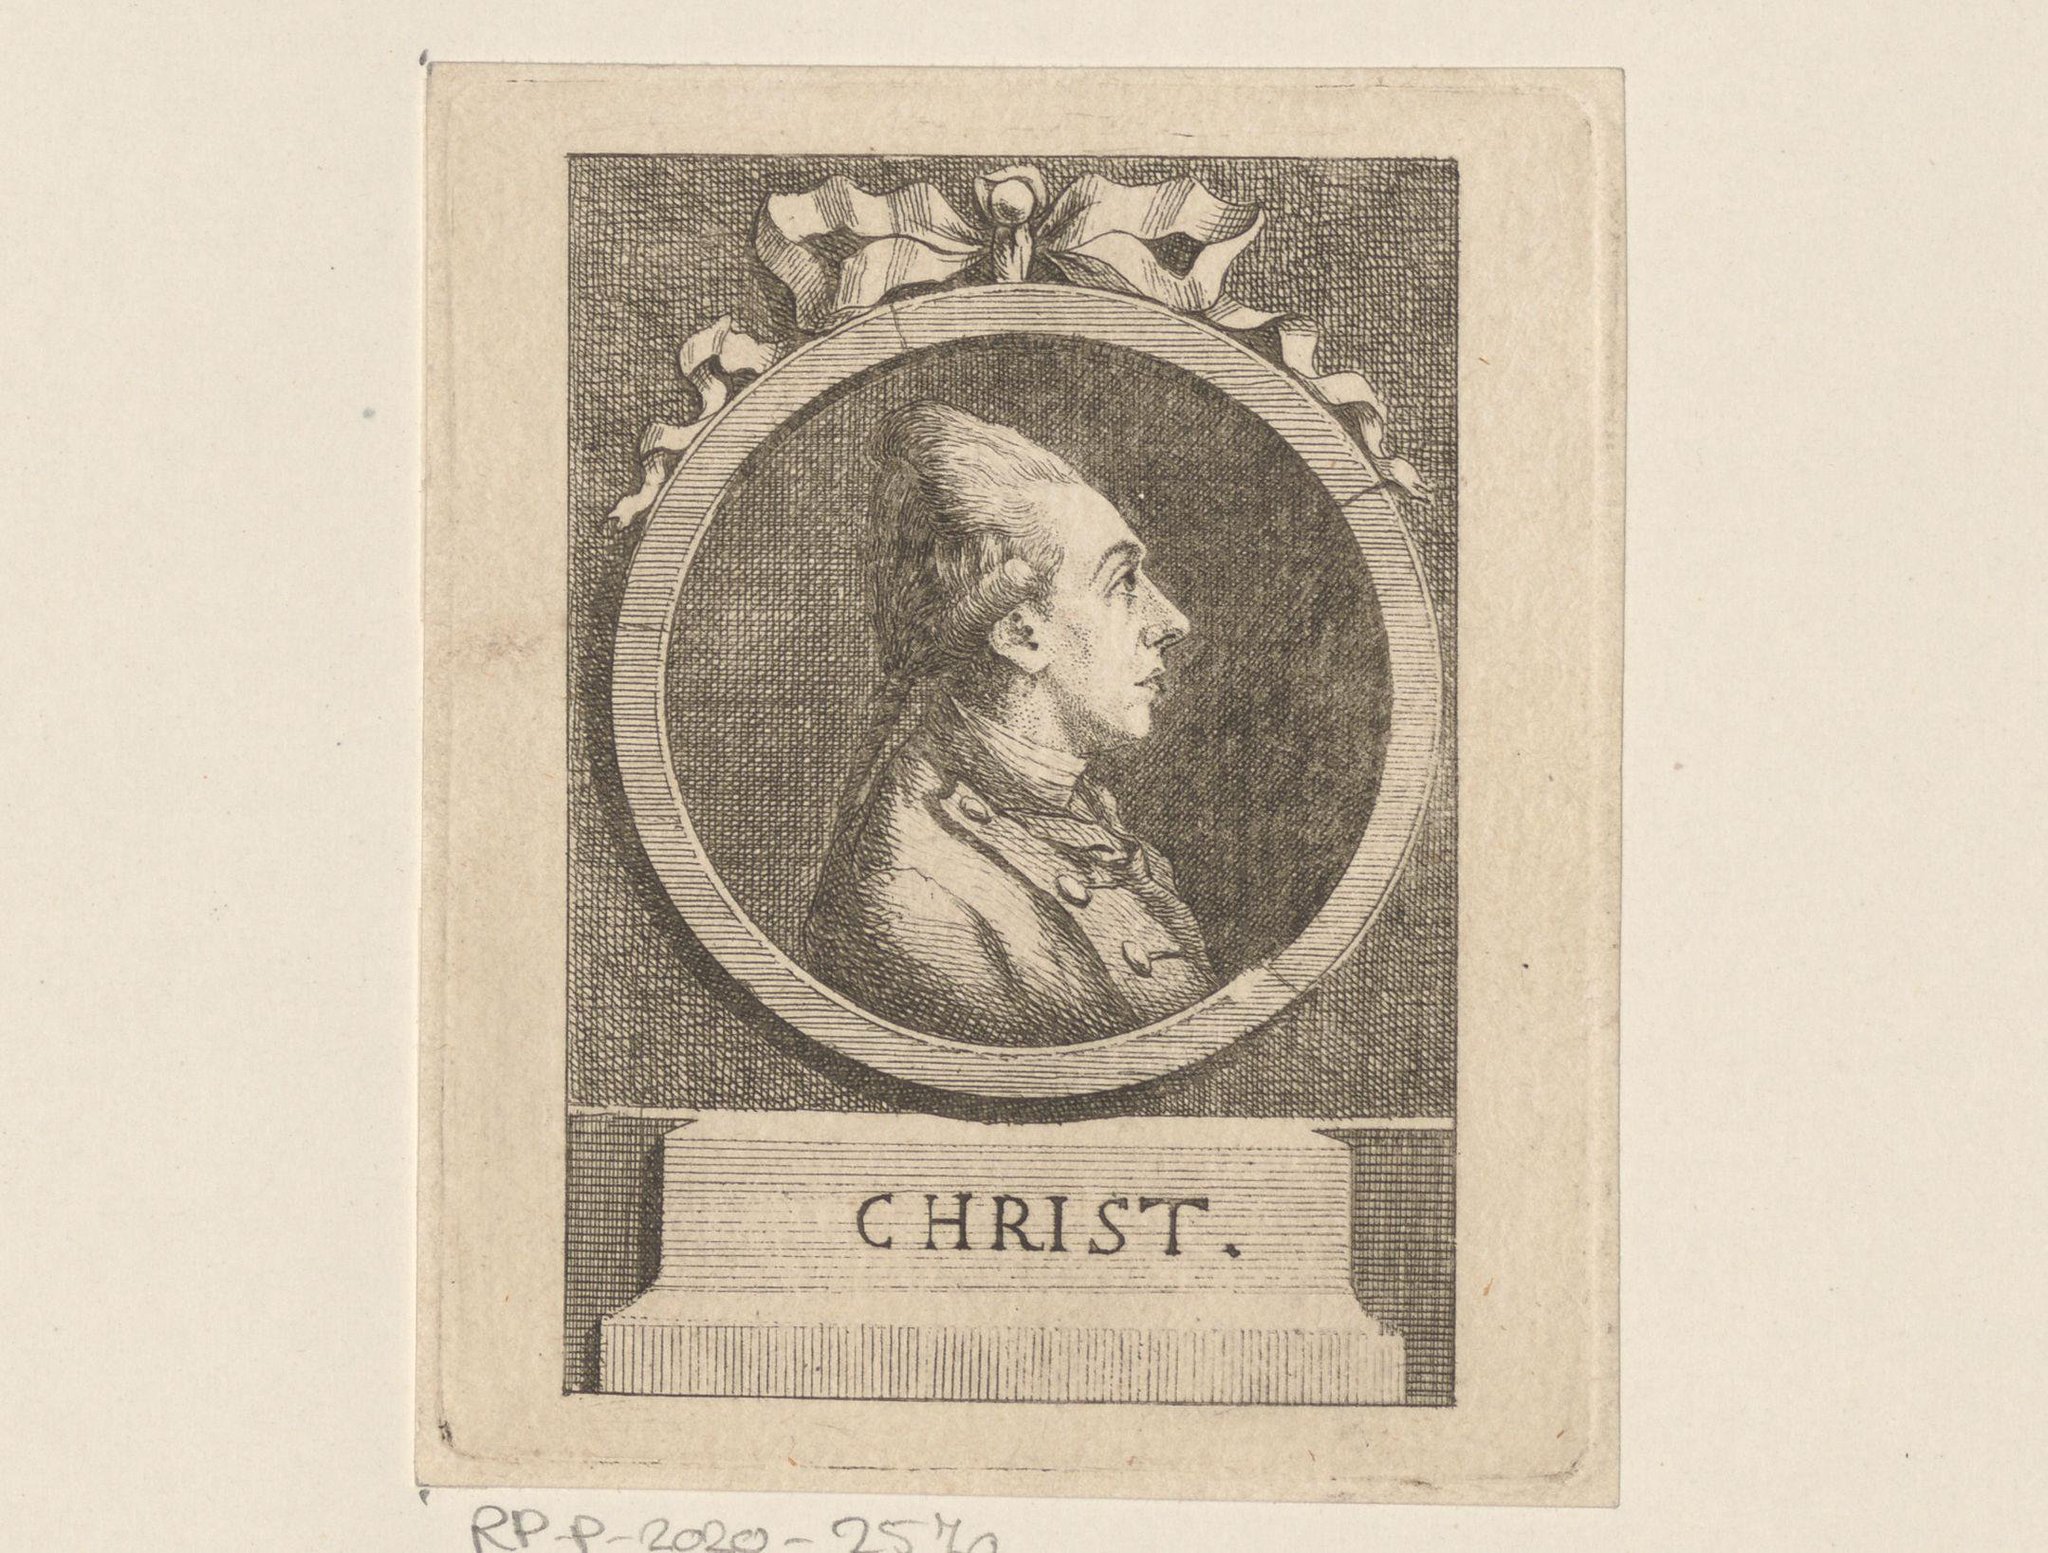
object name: print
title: Portret van Johann Friedrich Christ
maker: Anonymous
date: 1740-1799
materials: paper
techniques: etching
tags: scholar, philosopher, historical persons